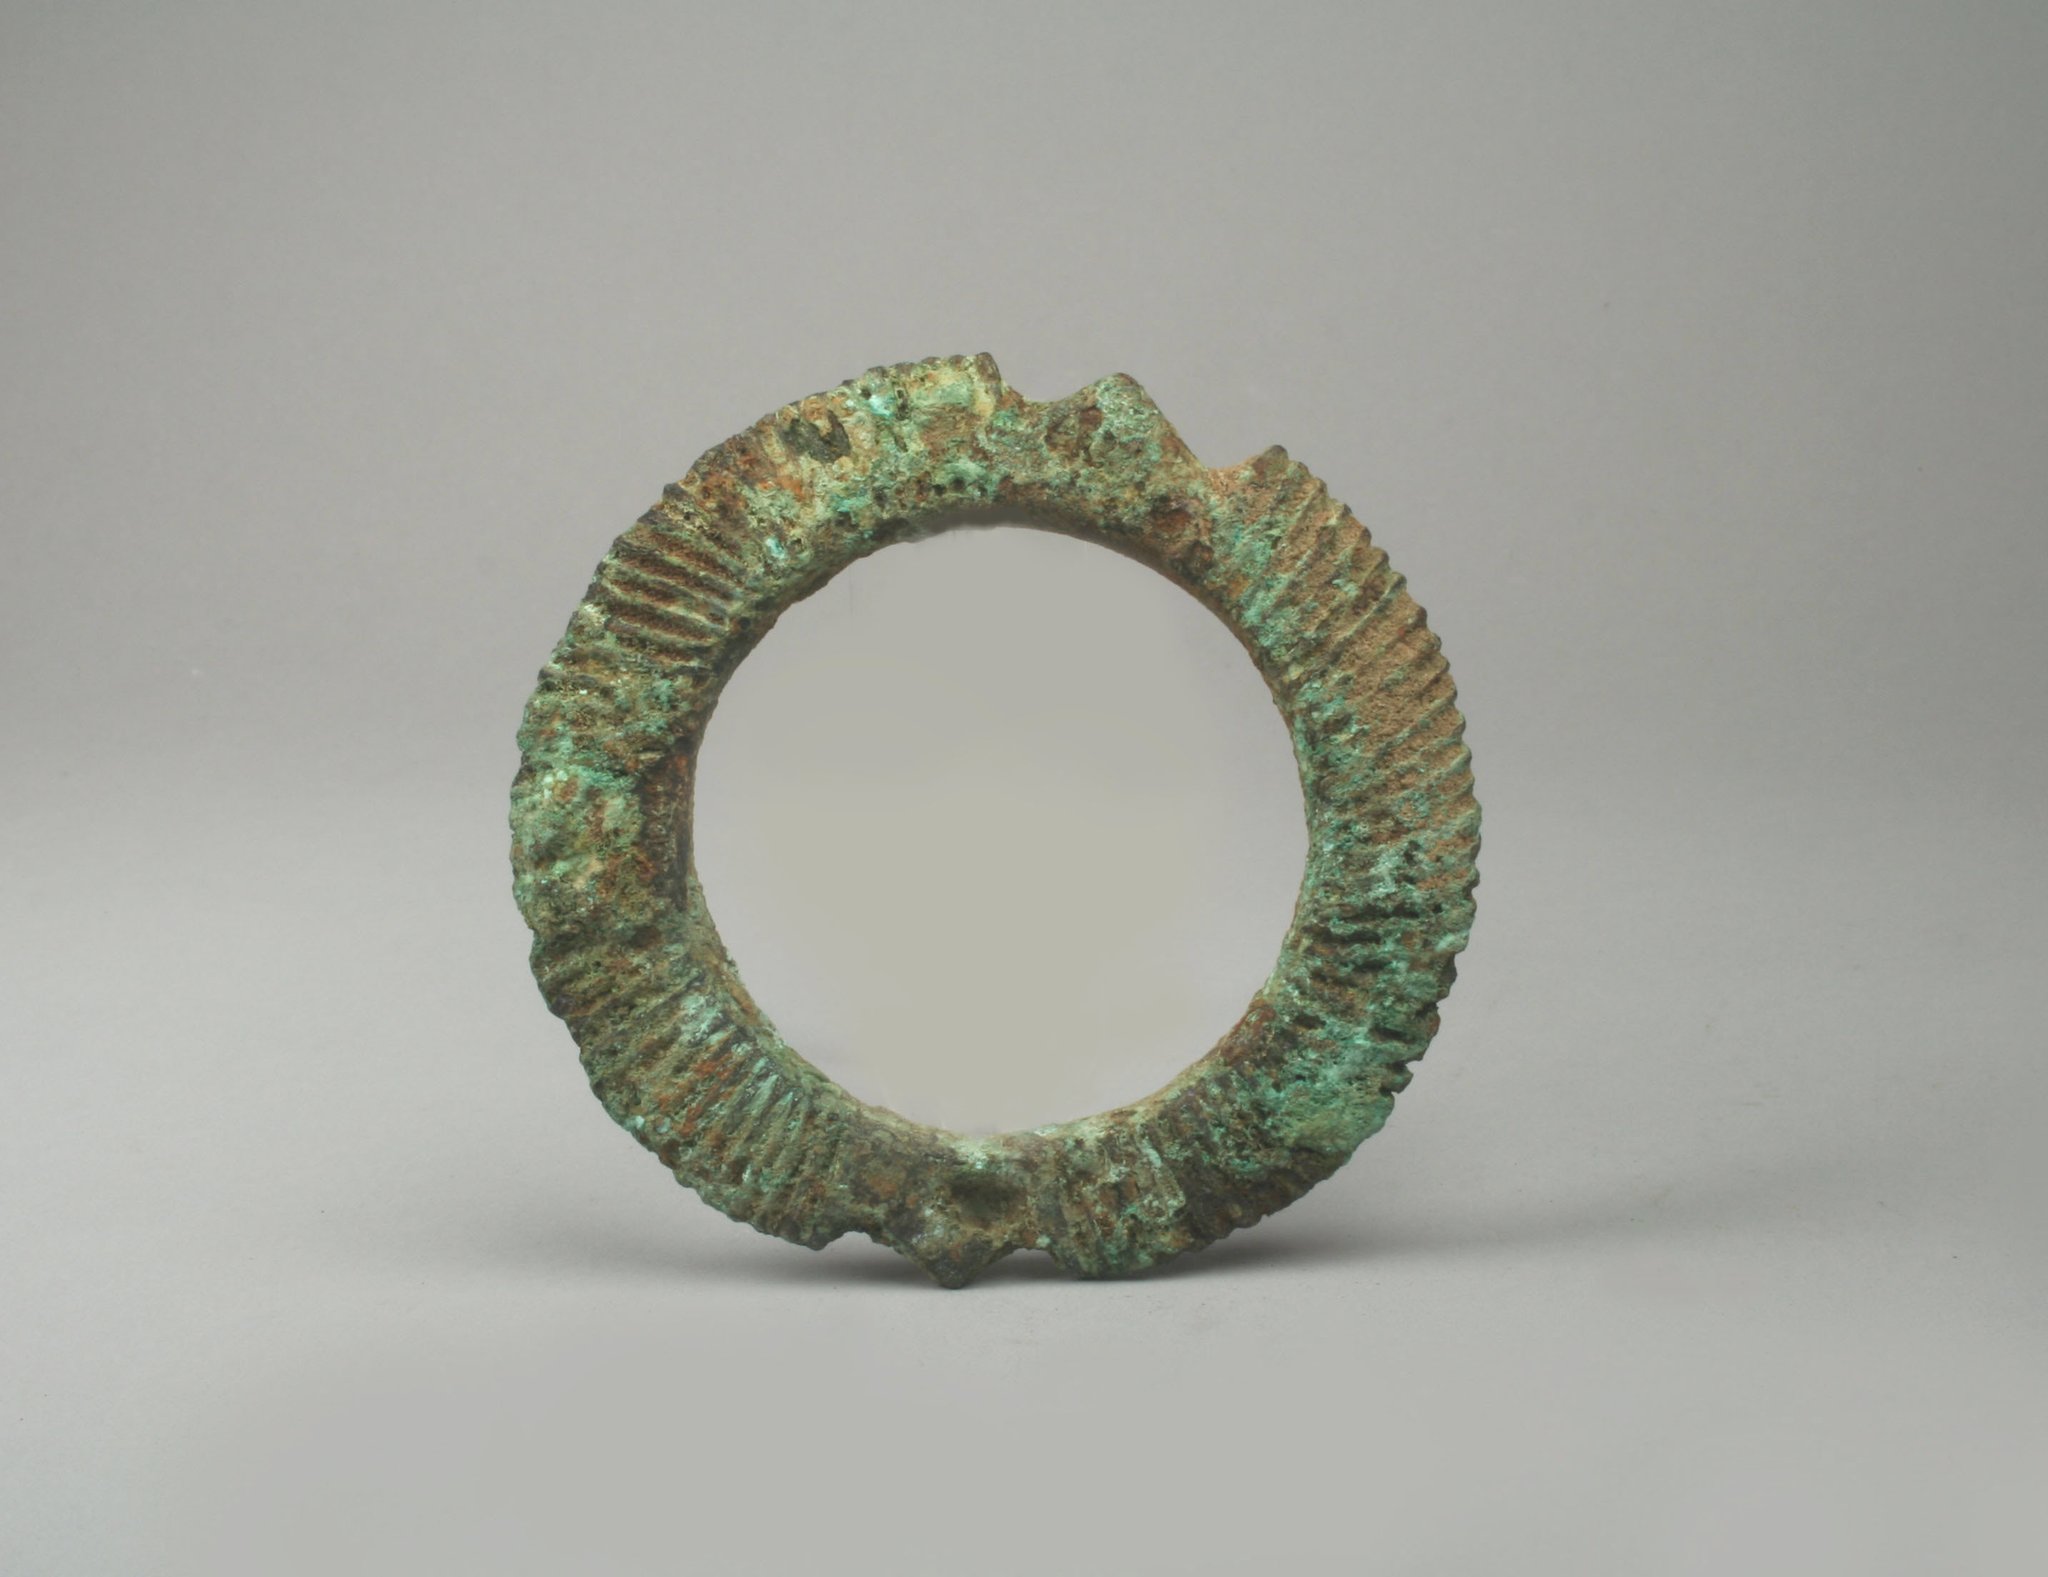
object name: bracelet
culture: middle niger civilization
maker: middle niger artist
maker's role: artist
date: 1001-1600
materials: copper alloy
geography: mali